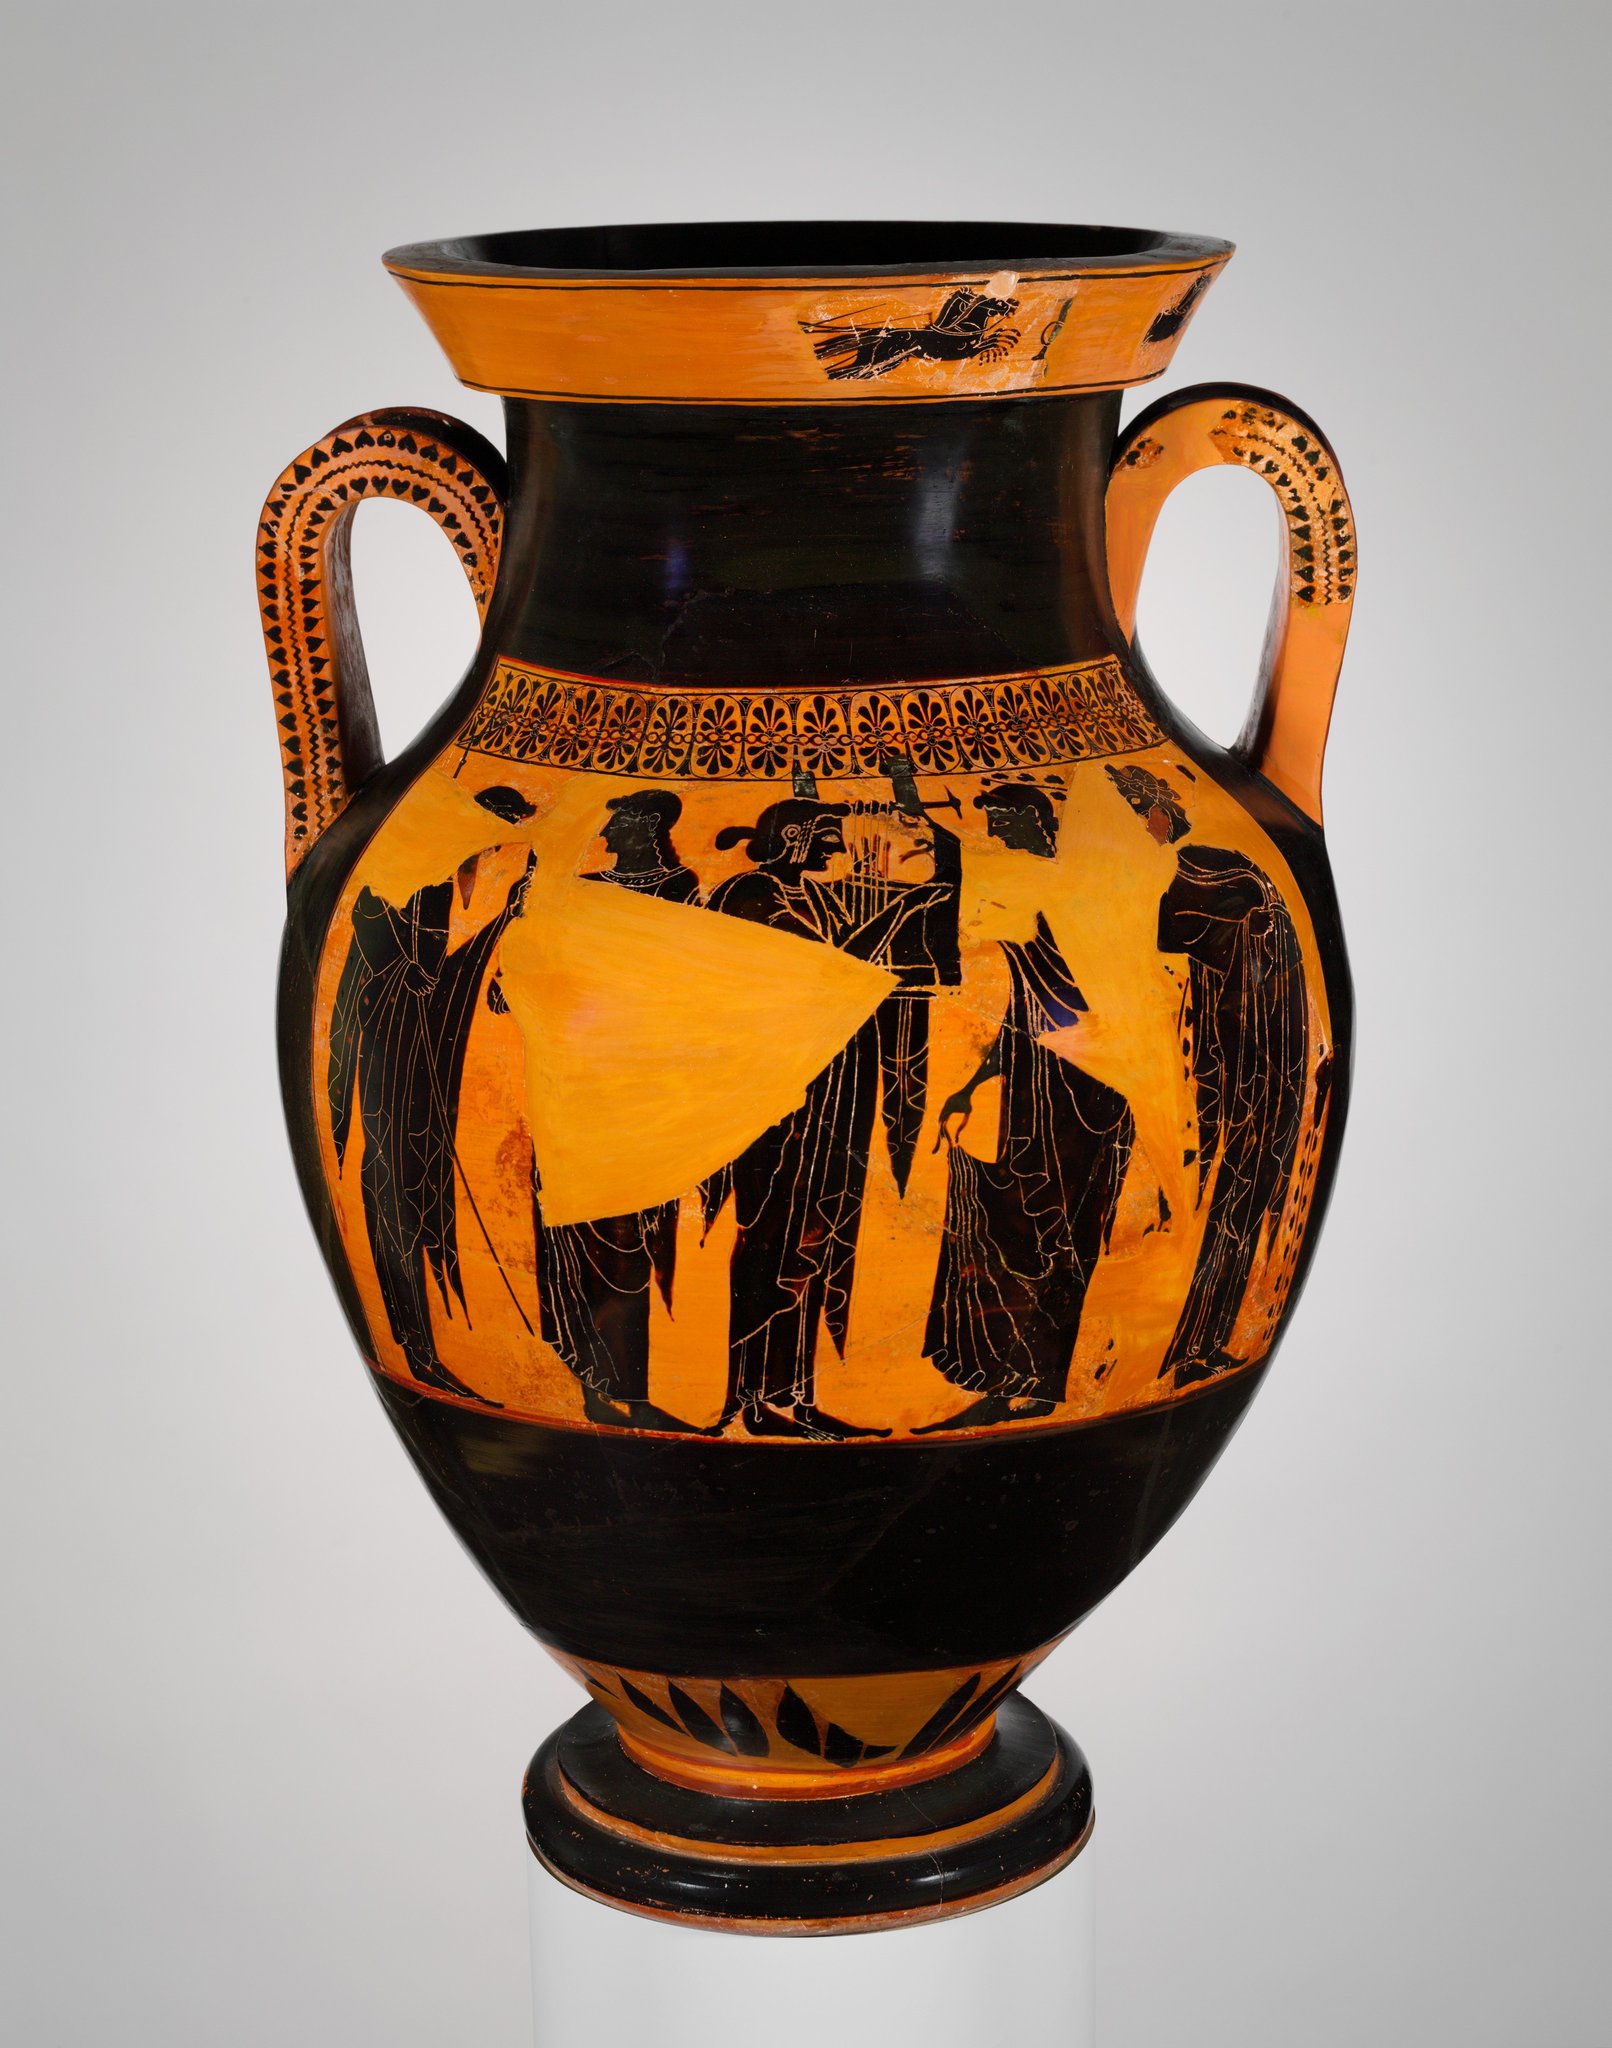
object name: amphora, type a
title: Terracotta amphora (jar)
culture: greek, attic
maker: antimenes painter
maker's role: artist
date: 530-520 BCE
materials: terracotta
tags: musical instruments,apollo,artemis,athena,dionysus,poseidon,horses,chariots